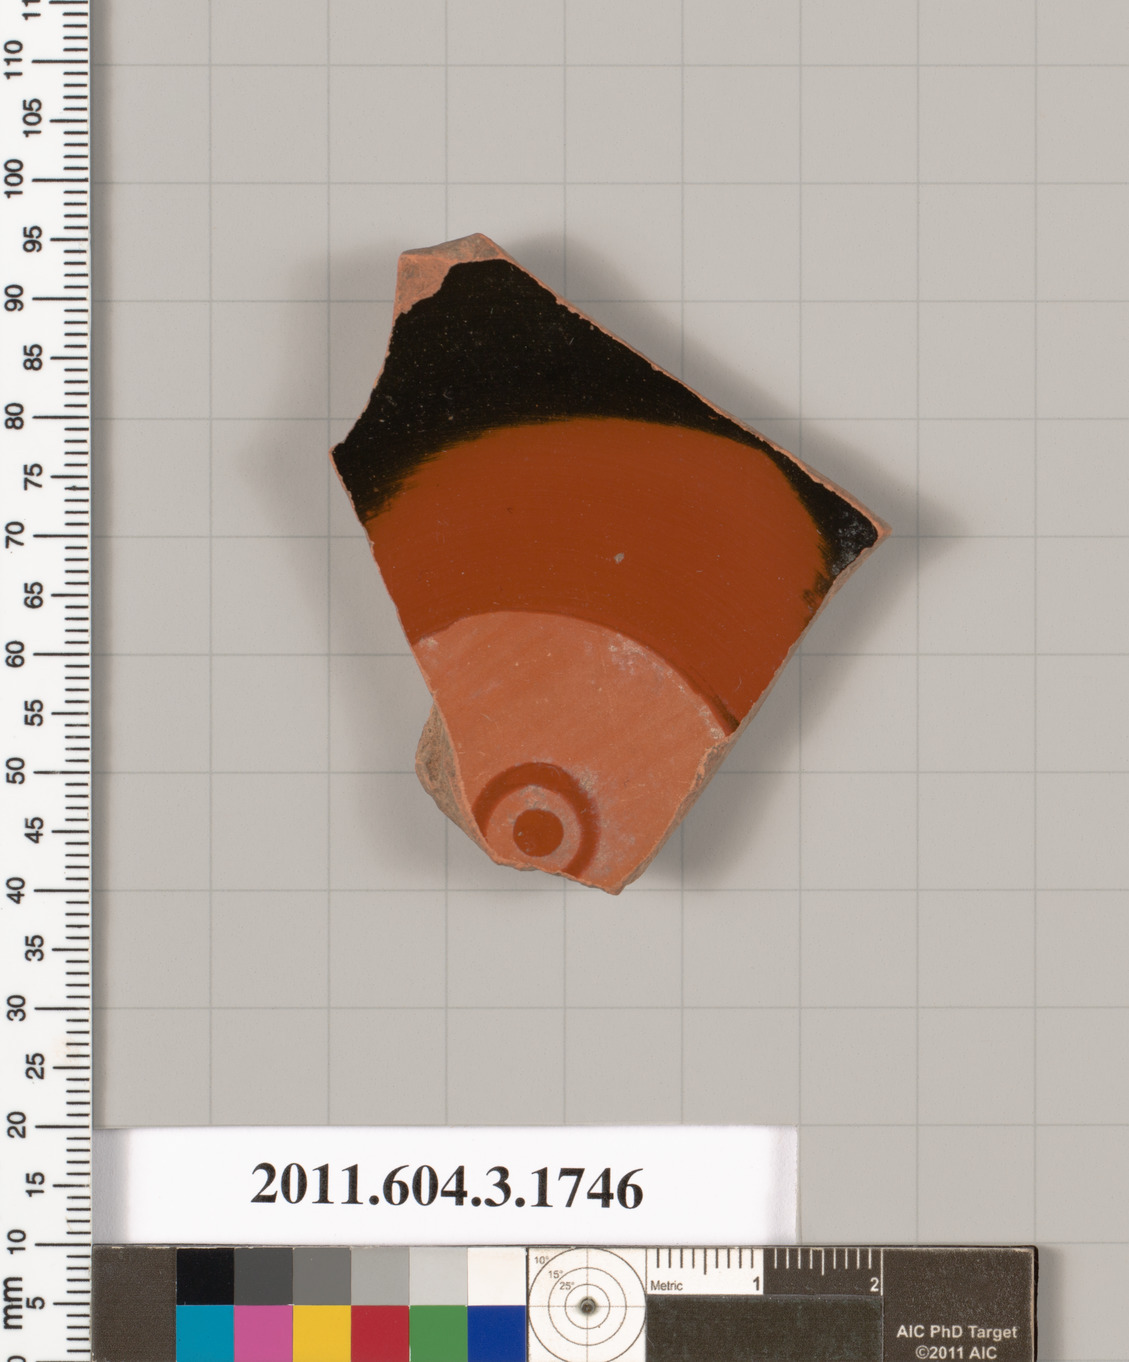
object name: kylix fragment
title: Terracotta fragment of a kylix: Band or lip cup (drinking cup)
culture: greek, attic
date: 550-526 BCE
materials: terracotta